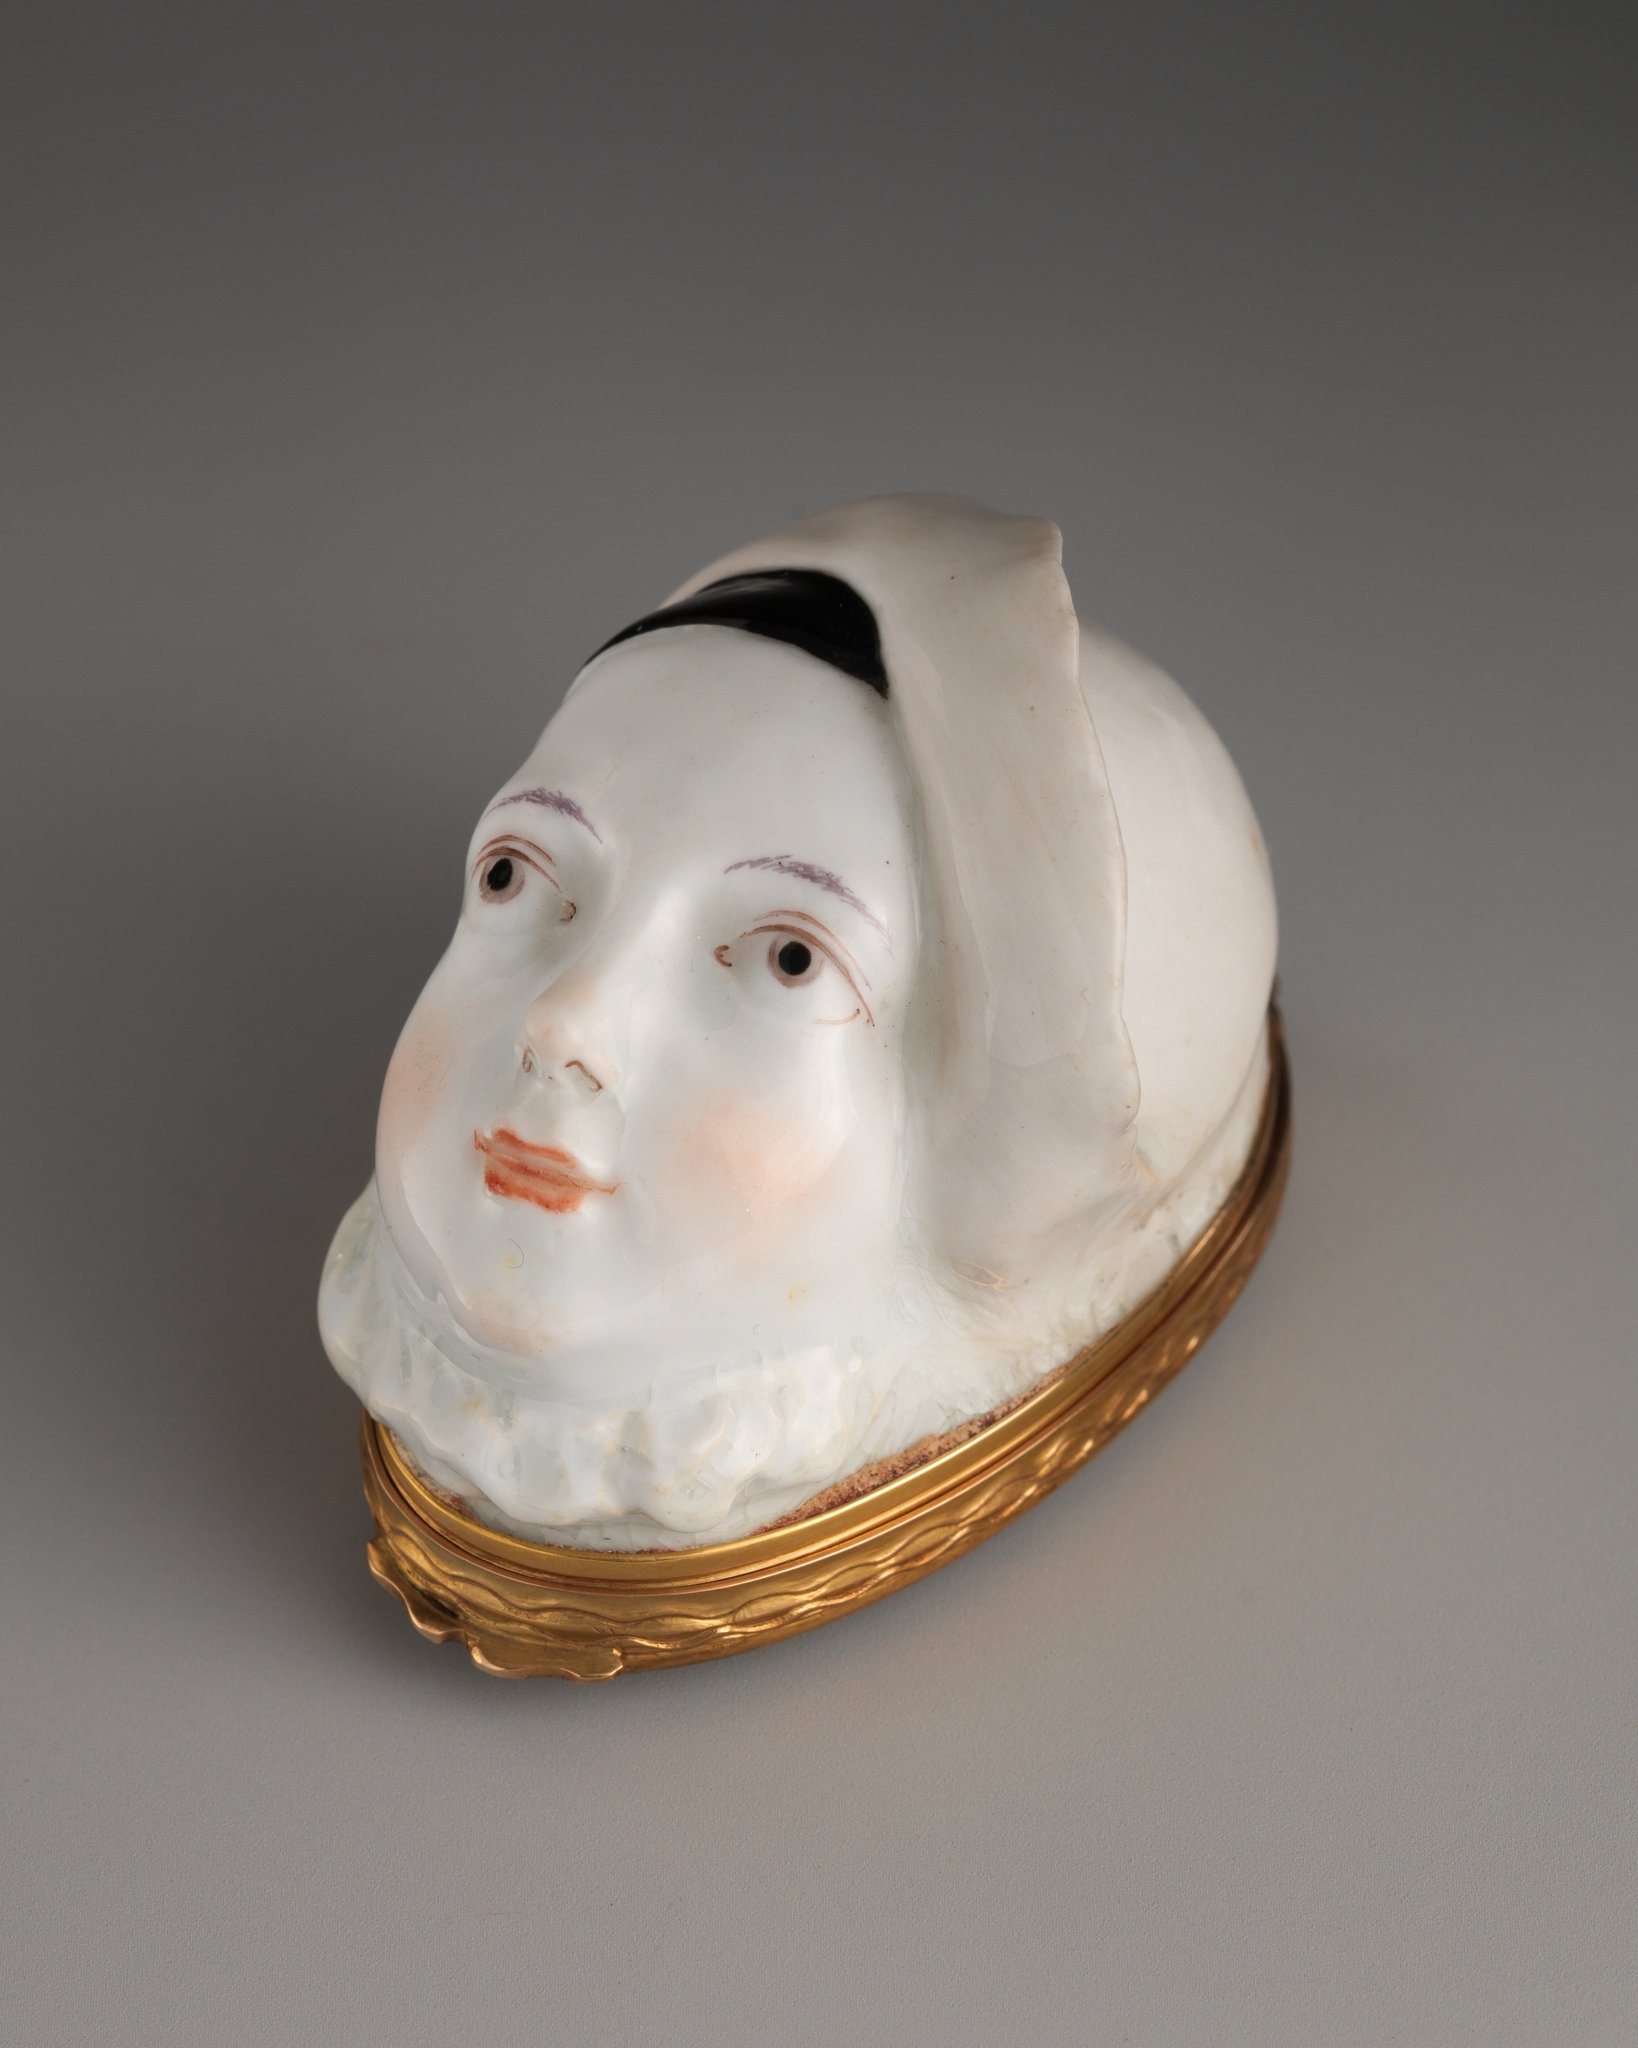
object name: toy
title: Head of Pierrot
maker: chelsea porcelain manufactory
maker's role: factory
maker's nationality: british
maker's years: 1744-1784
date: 1758-1759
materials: soft paste porcelain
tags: heads